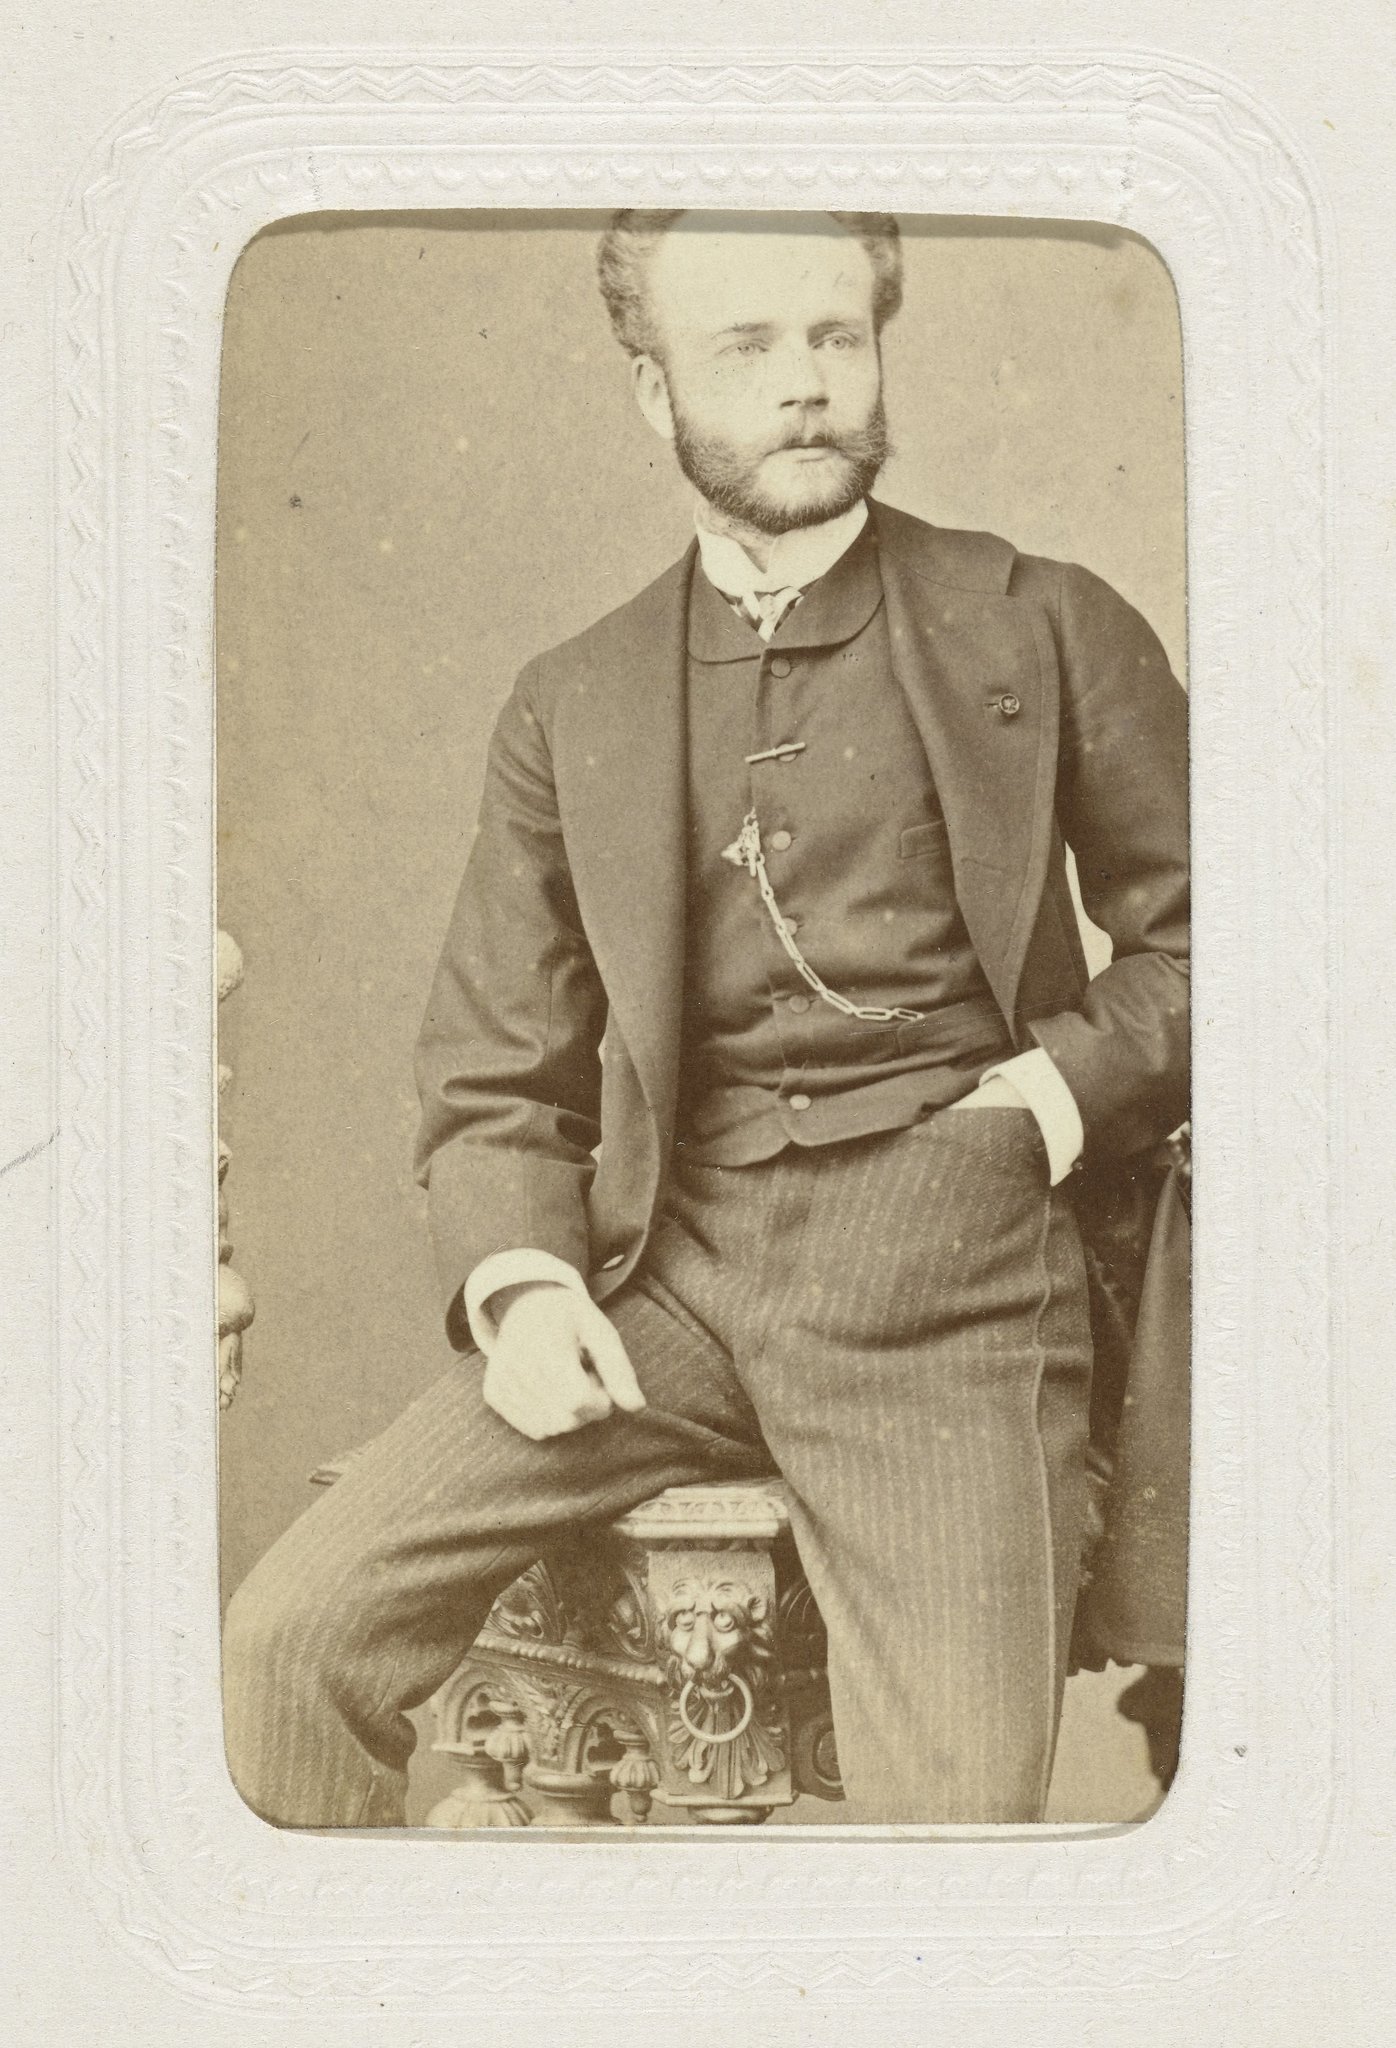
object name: carte de visite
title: Studioportret van een man met snor en baard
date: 1863-1866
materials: cardboard, paper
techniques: albumen print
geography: istanbul